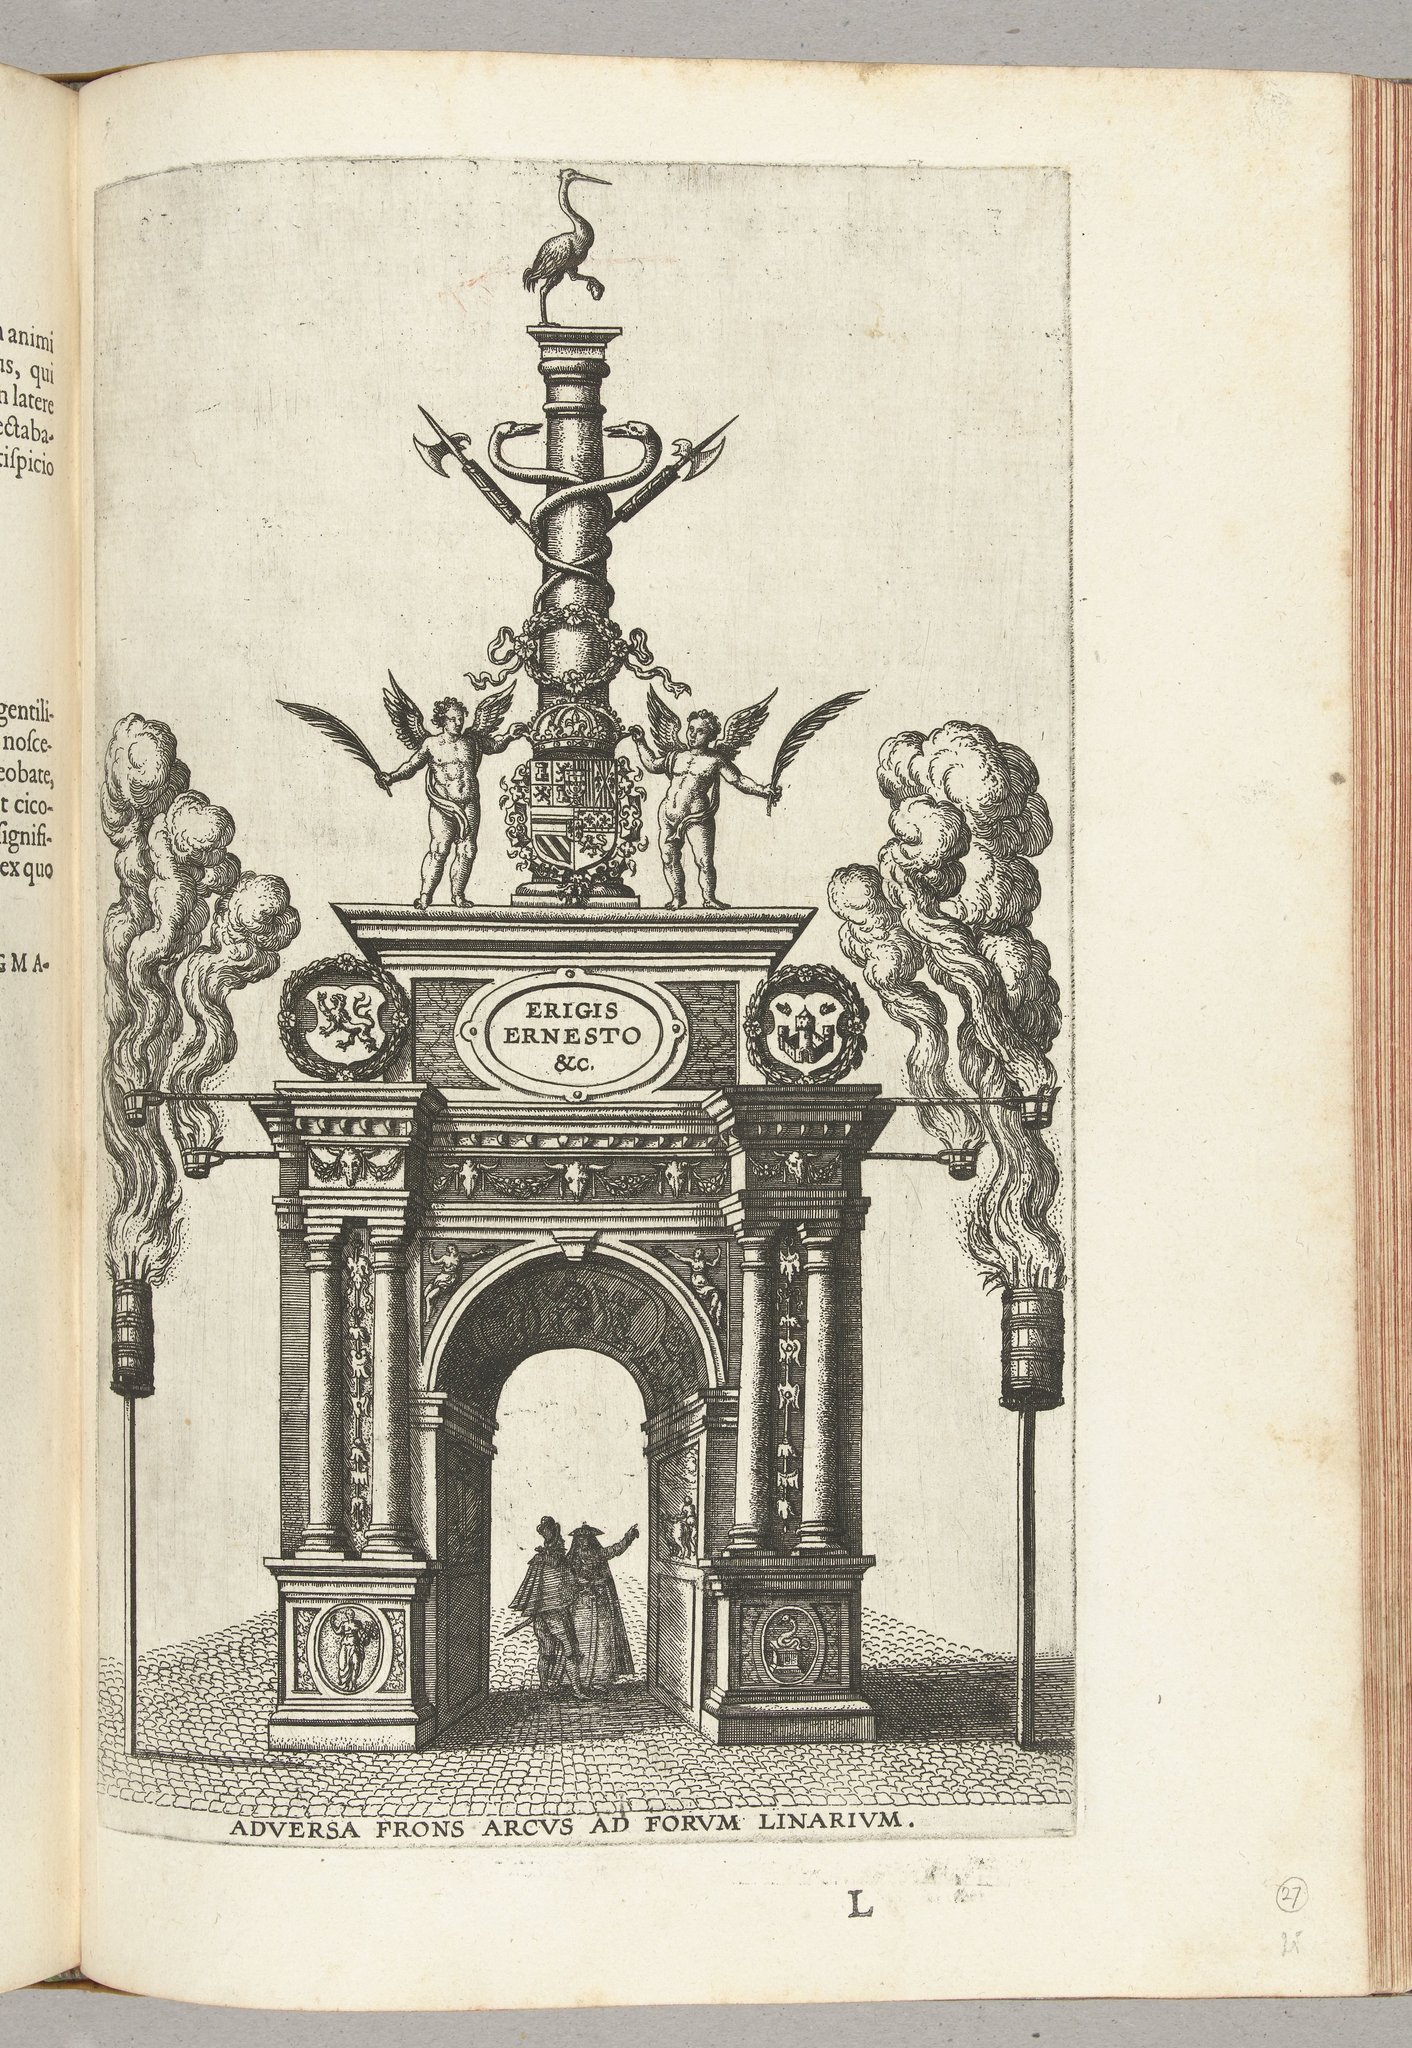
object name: print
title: Adversa Frons Arcus ad Forum Linarium.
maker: pieter van der borcht (i)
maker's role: print maker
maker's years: 1545-1608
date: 1594-1595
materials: paper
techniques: etching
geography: antwerp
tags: vienna, triumphal entry and public reception, pageant, 'entrée solennelle', 'joyeuse entrée', antwerp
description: Triomfboog ter ere van de stad Antwerpen (achterzijde). Opgesteld in de Hoogstraat bij de Vlasmarkt. Bekroond met een kraanvogel. Onderdeel van de beschrijving van de intocht van aartshertog Ernst te Antwerpen, 18 juli 1594, door Joannes Bochius, Descriptio publicae gratulationis, spectaculorum et ludorum, in adventu Sereniss. Principis Ernesti Archiducis Austriae, Ex Officina Plantiniana, Antwerpen 1595.